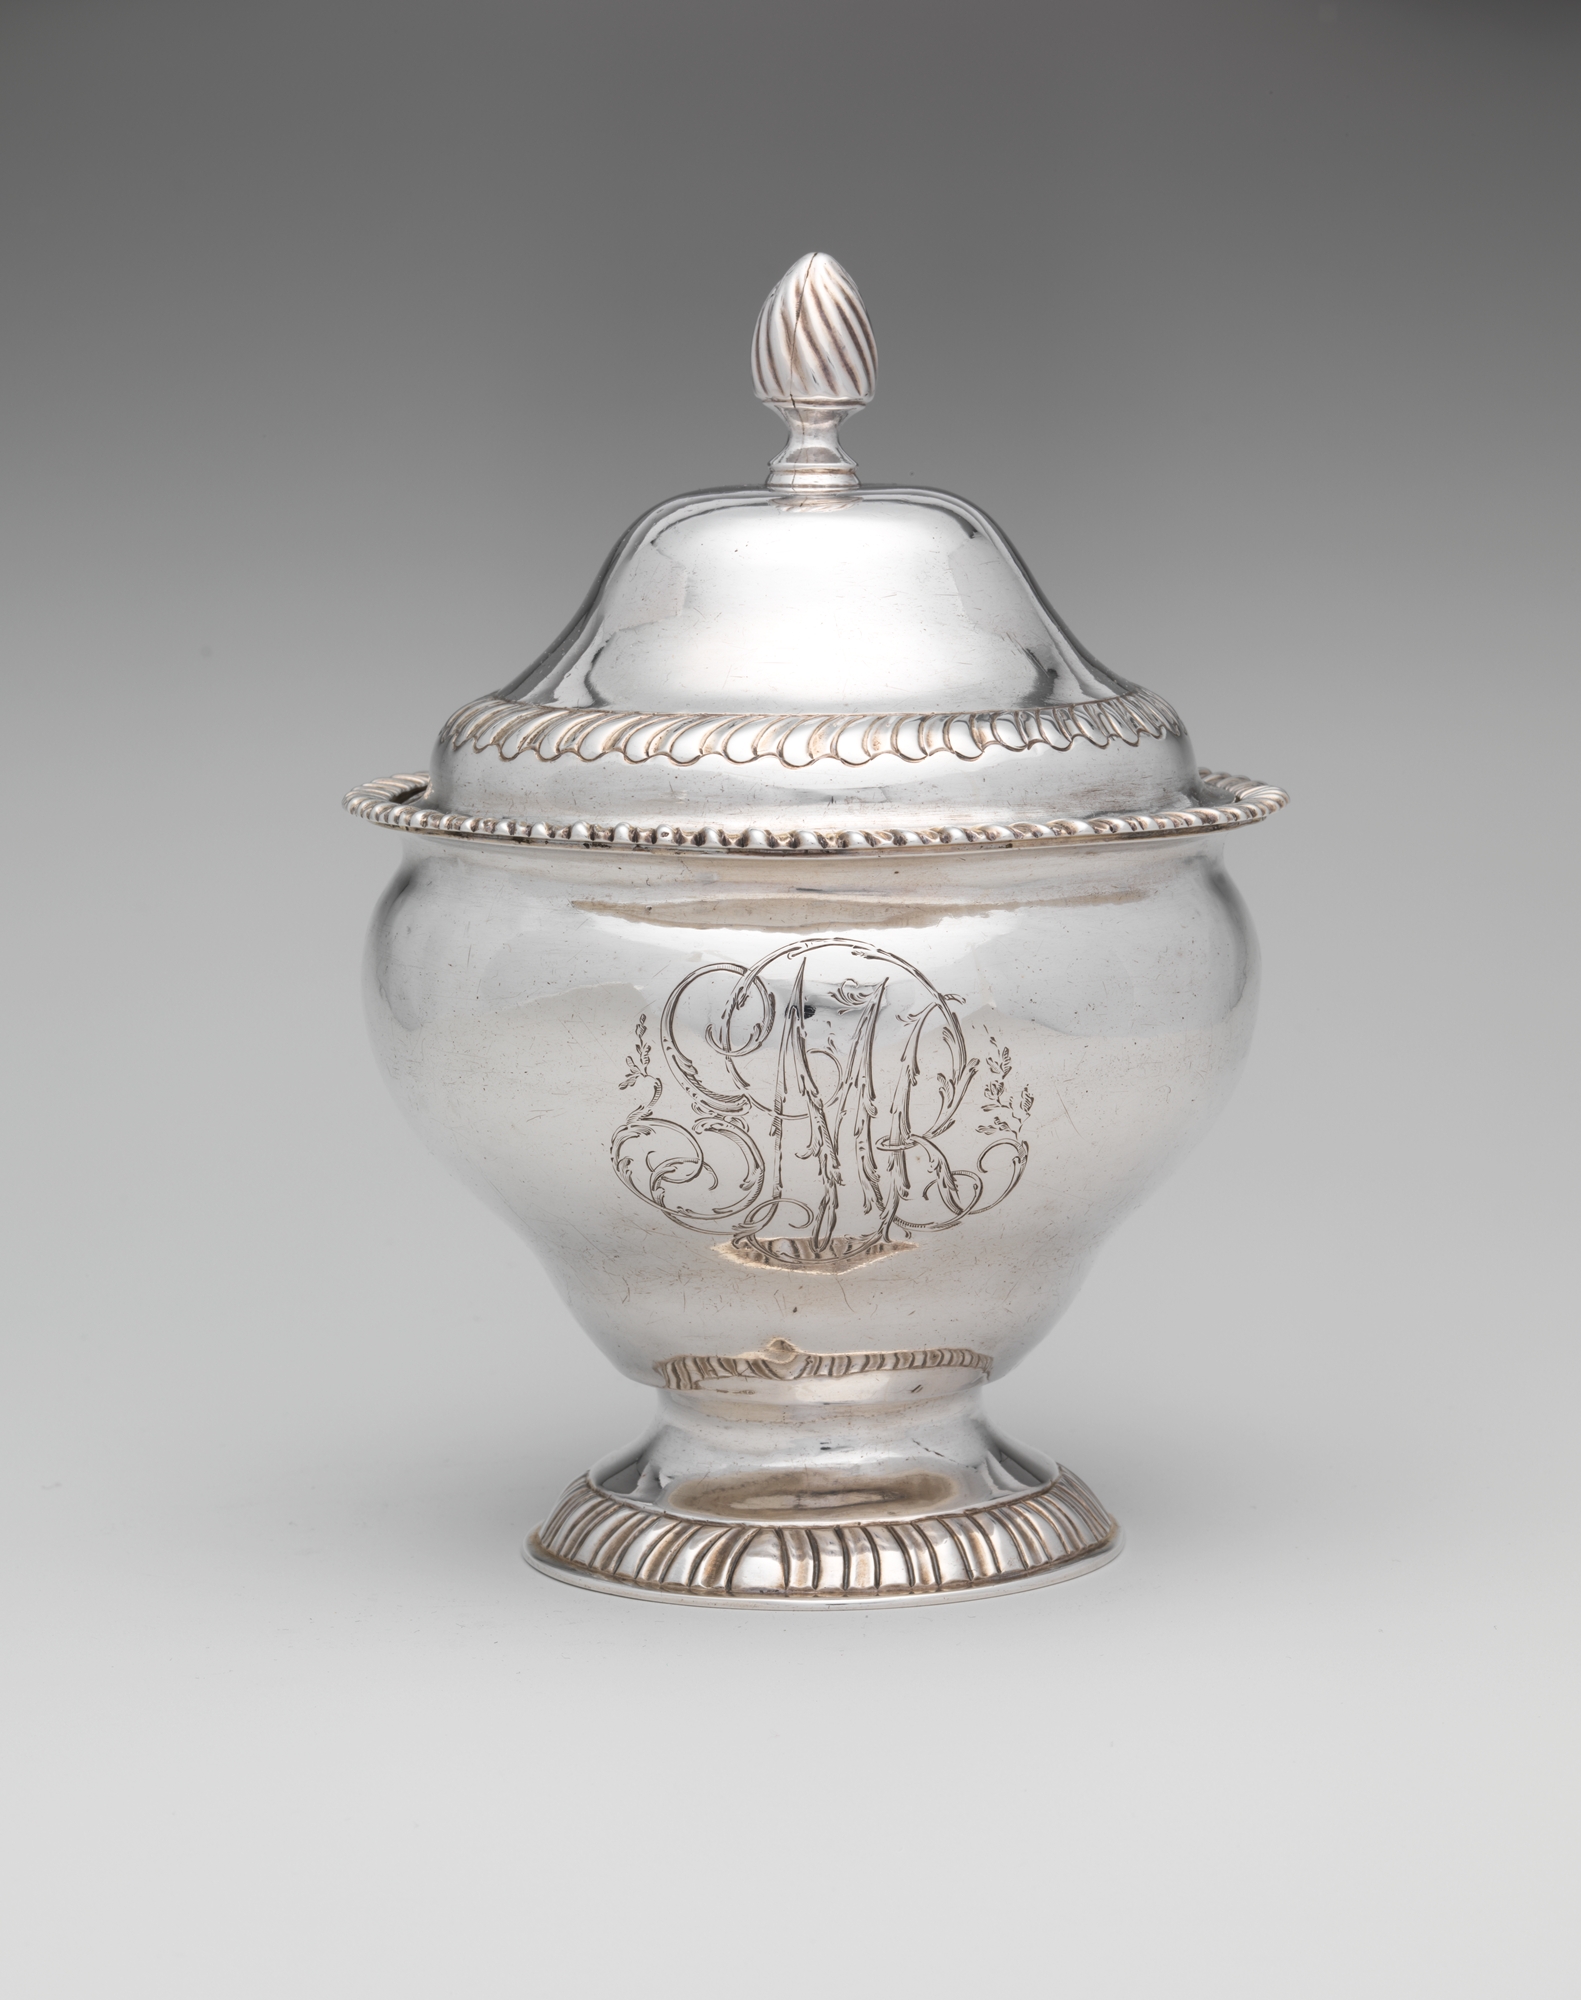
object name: sugar bowl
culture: american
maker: thomas shields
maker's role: maker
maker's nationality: american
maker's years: 1742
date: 1765-1785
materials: silver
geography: united states